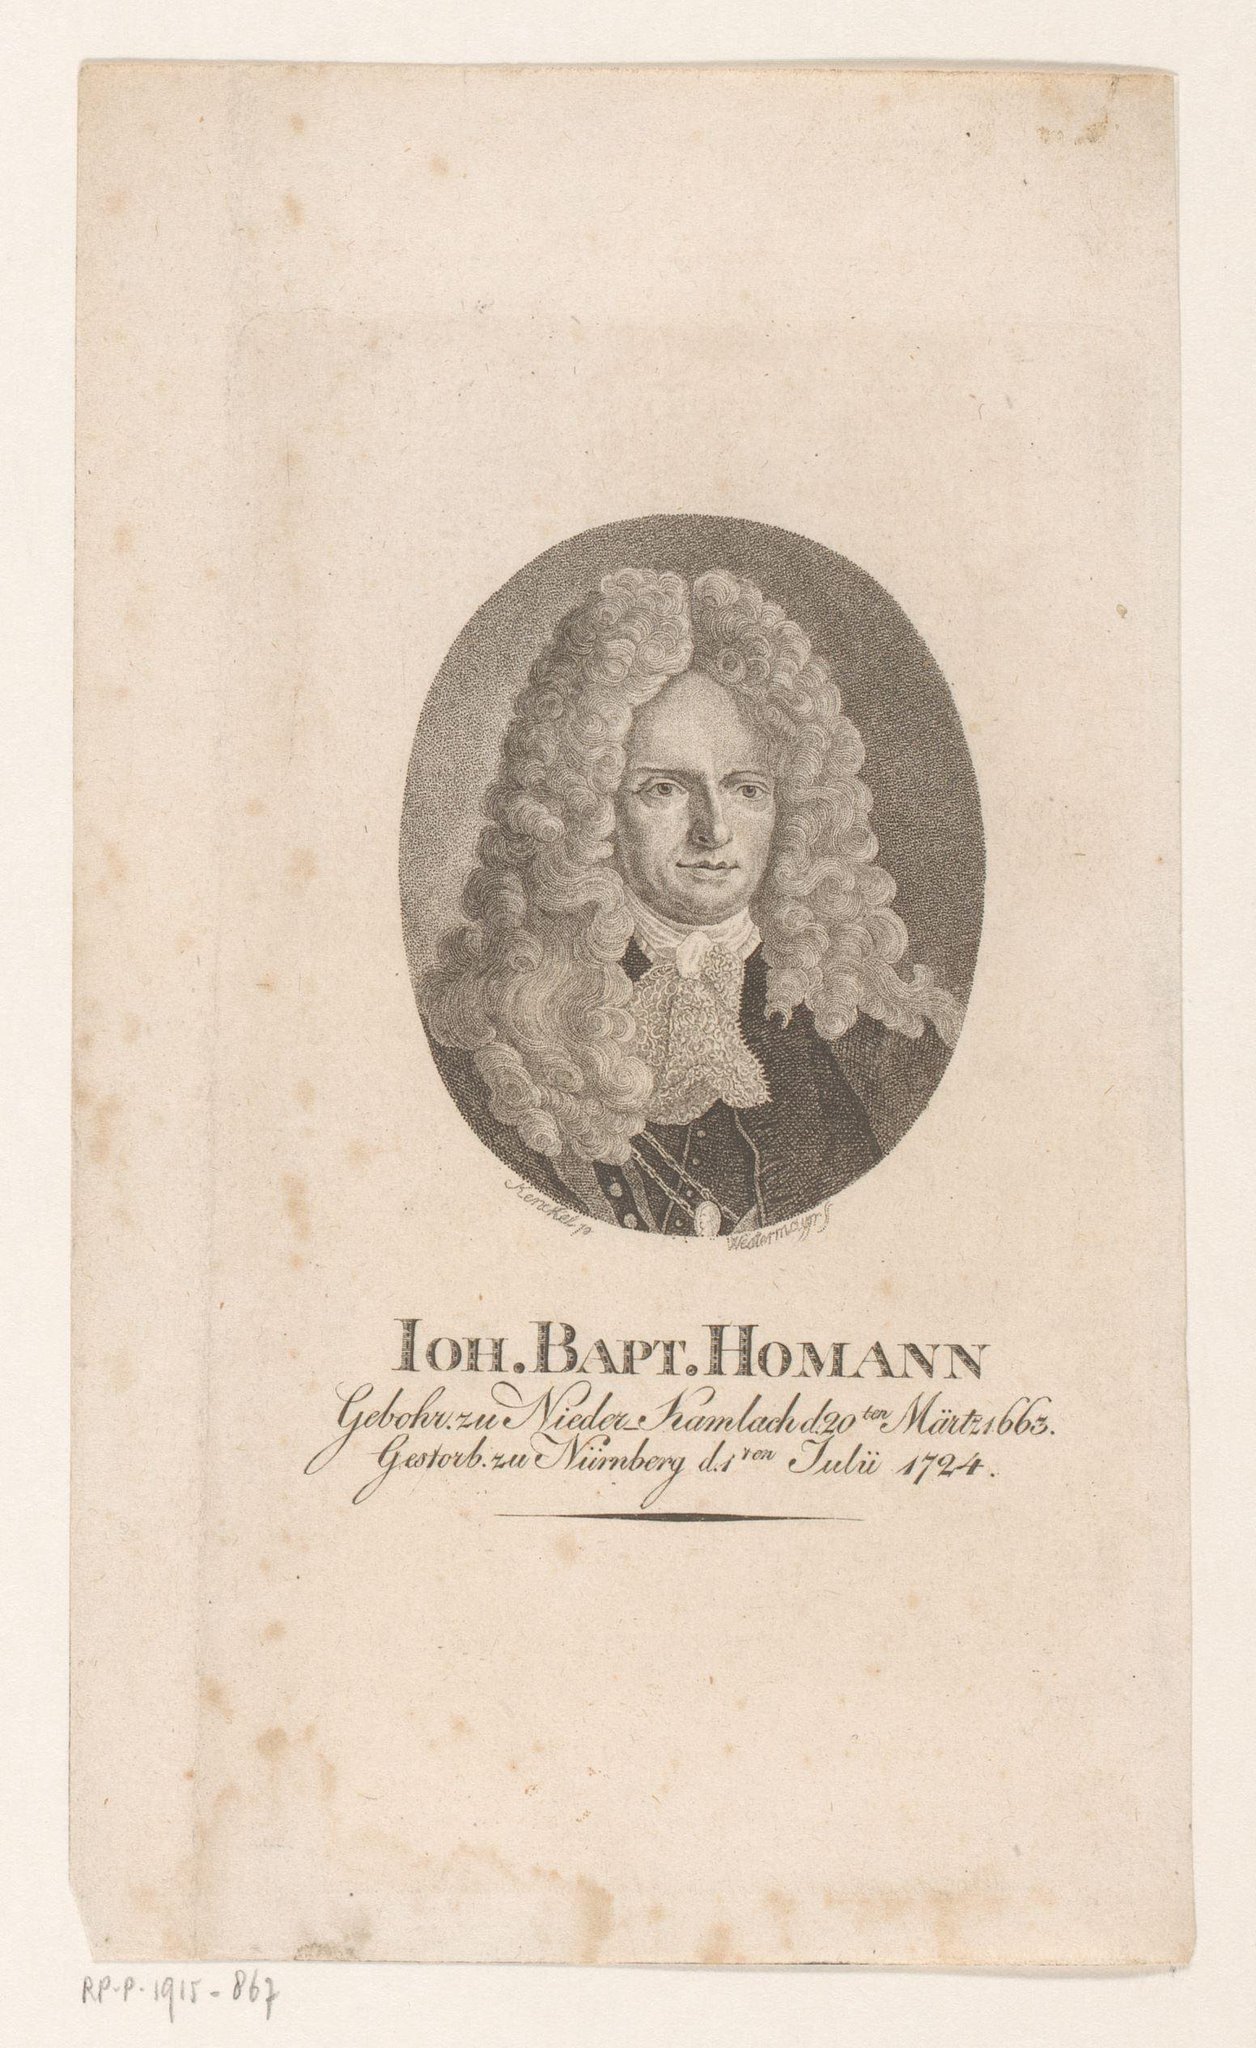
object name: print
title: Portret van Johann Baptist Homann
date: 1775-1834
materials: paper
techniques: engraving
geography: germany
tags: print maker, publisher, historical persons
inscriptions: collector's mark: Lugt 2228